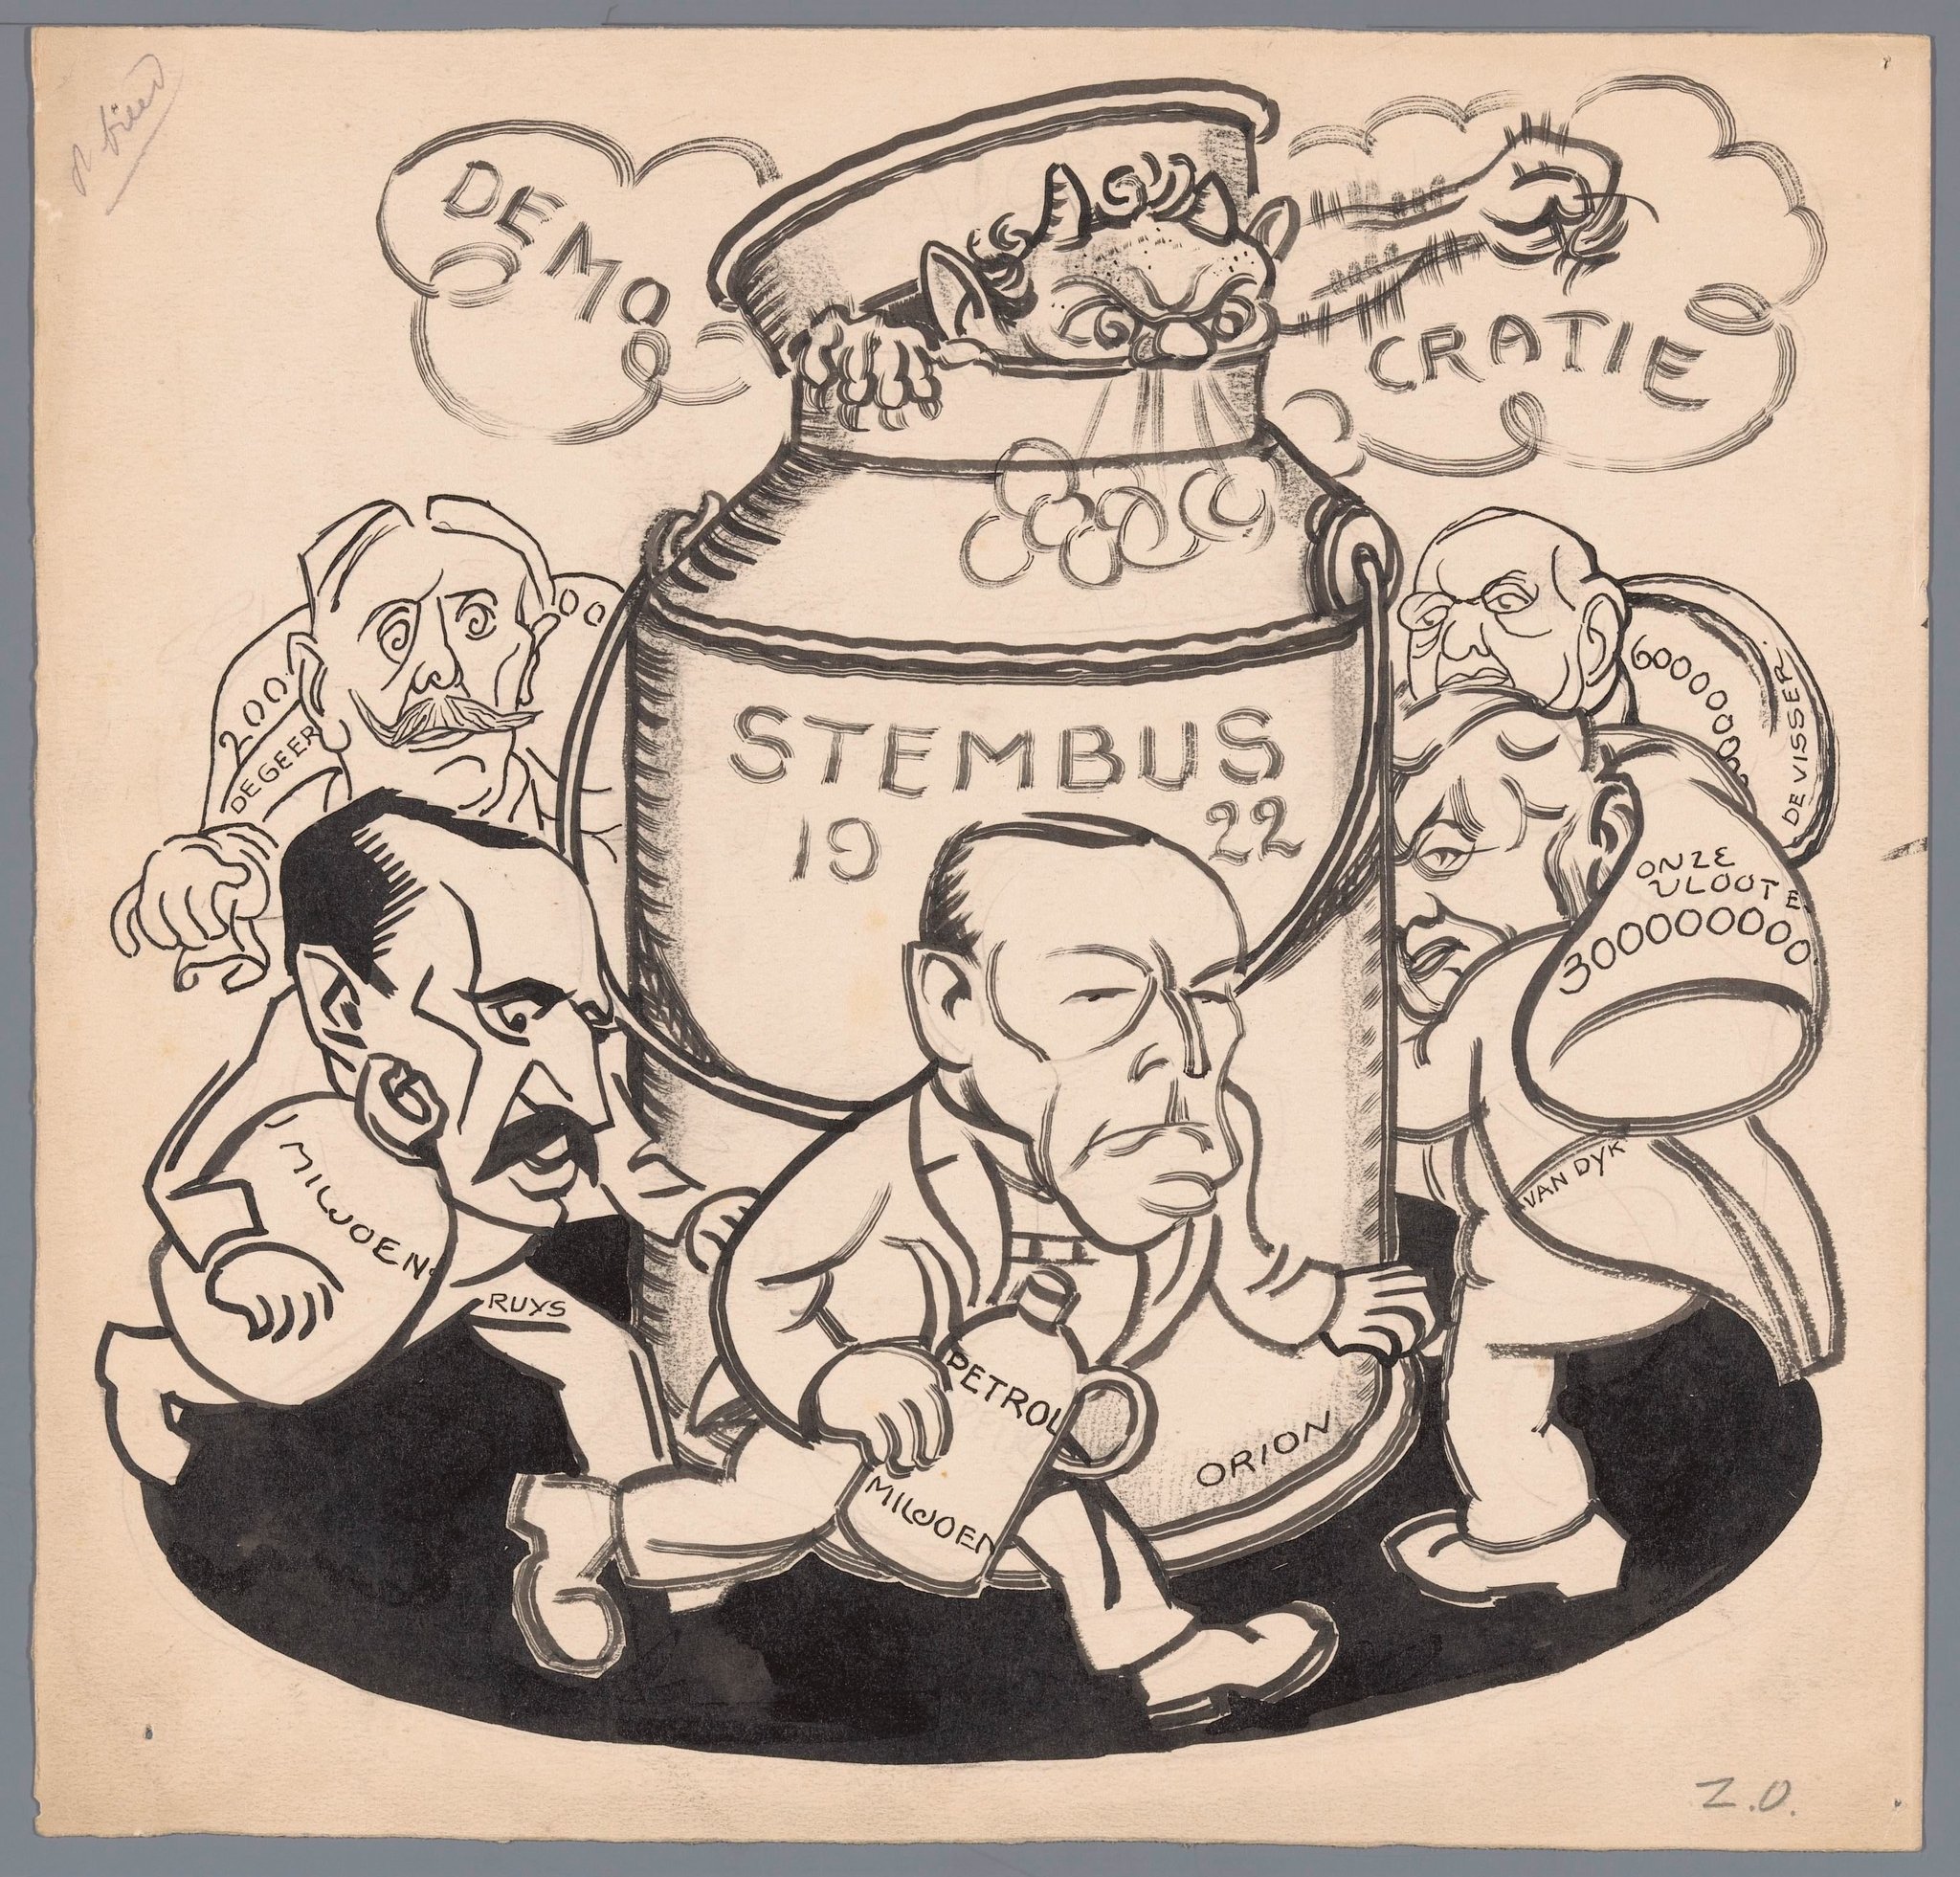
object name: cartoon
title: Democratische schemeringen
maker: patricq kroon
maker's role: draughtsman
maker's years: 1862-1941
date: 1922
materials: chalk, ink, paper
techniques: brush, pen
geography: netherlands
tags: politician, utrecht, voting, election, political caricatures and satires, netherlands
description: De Tweede Kamerverkiezingen 1922. Ministers van het Kabinet-Ruijs de Beerenbrouck I dansen met geldzakken om een een stembus waaruit een briesende duivel tevoorschijn komt. Ontwerp voor een politieke spotprent.